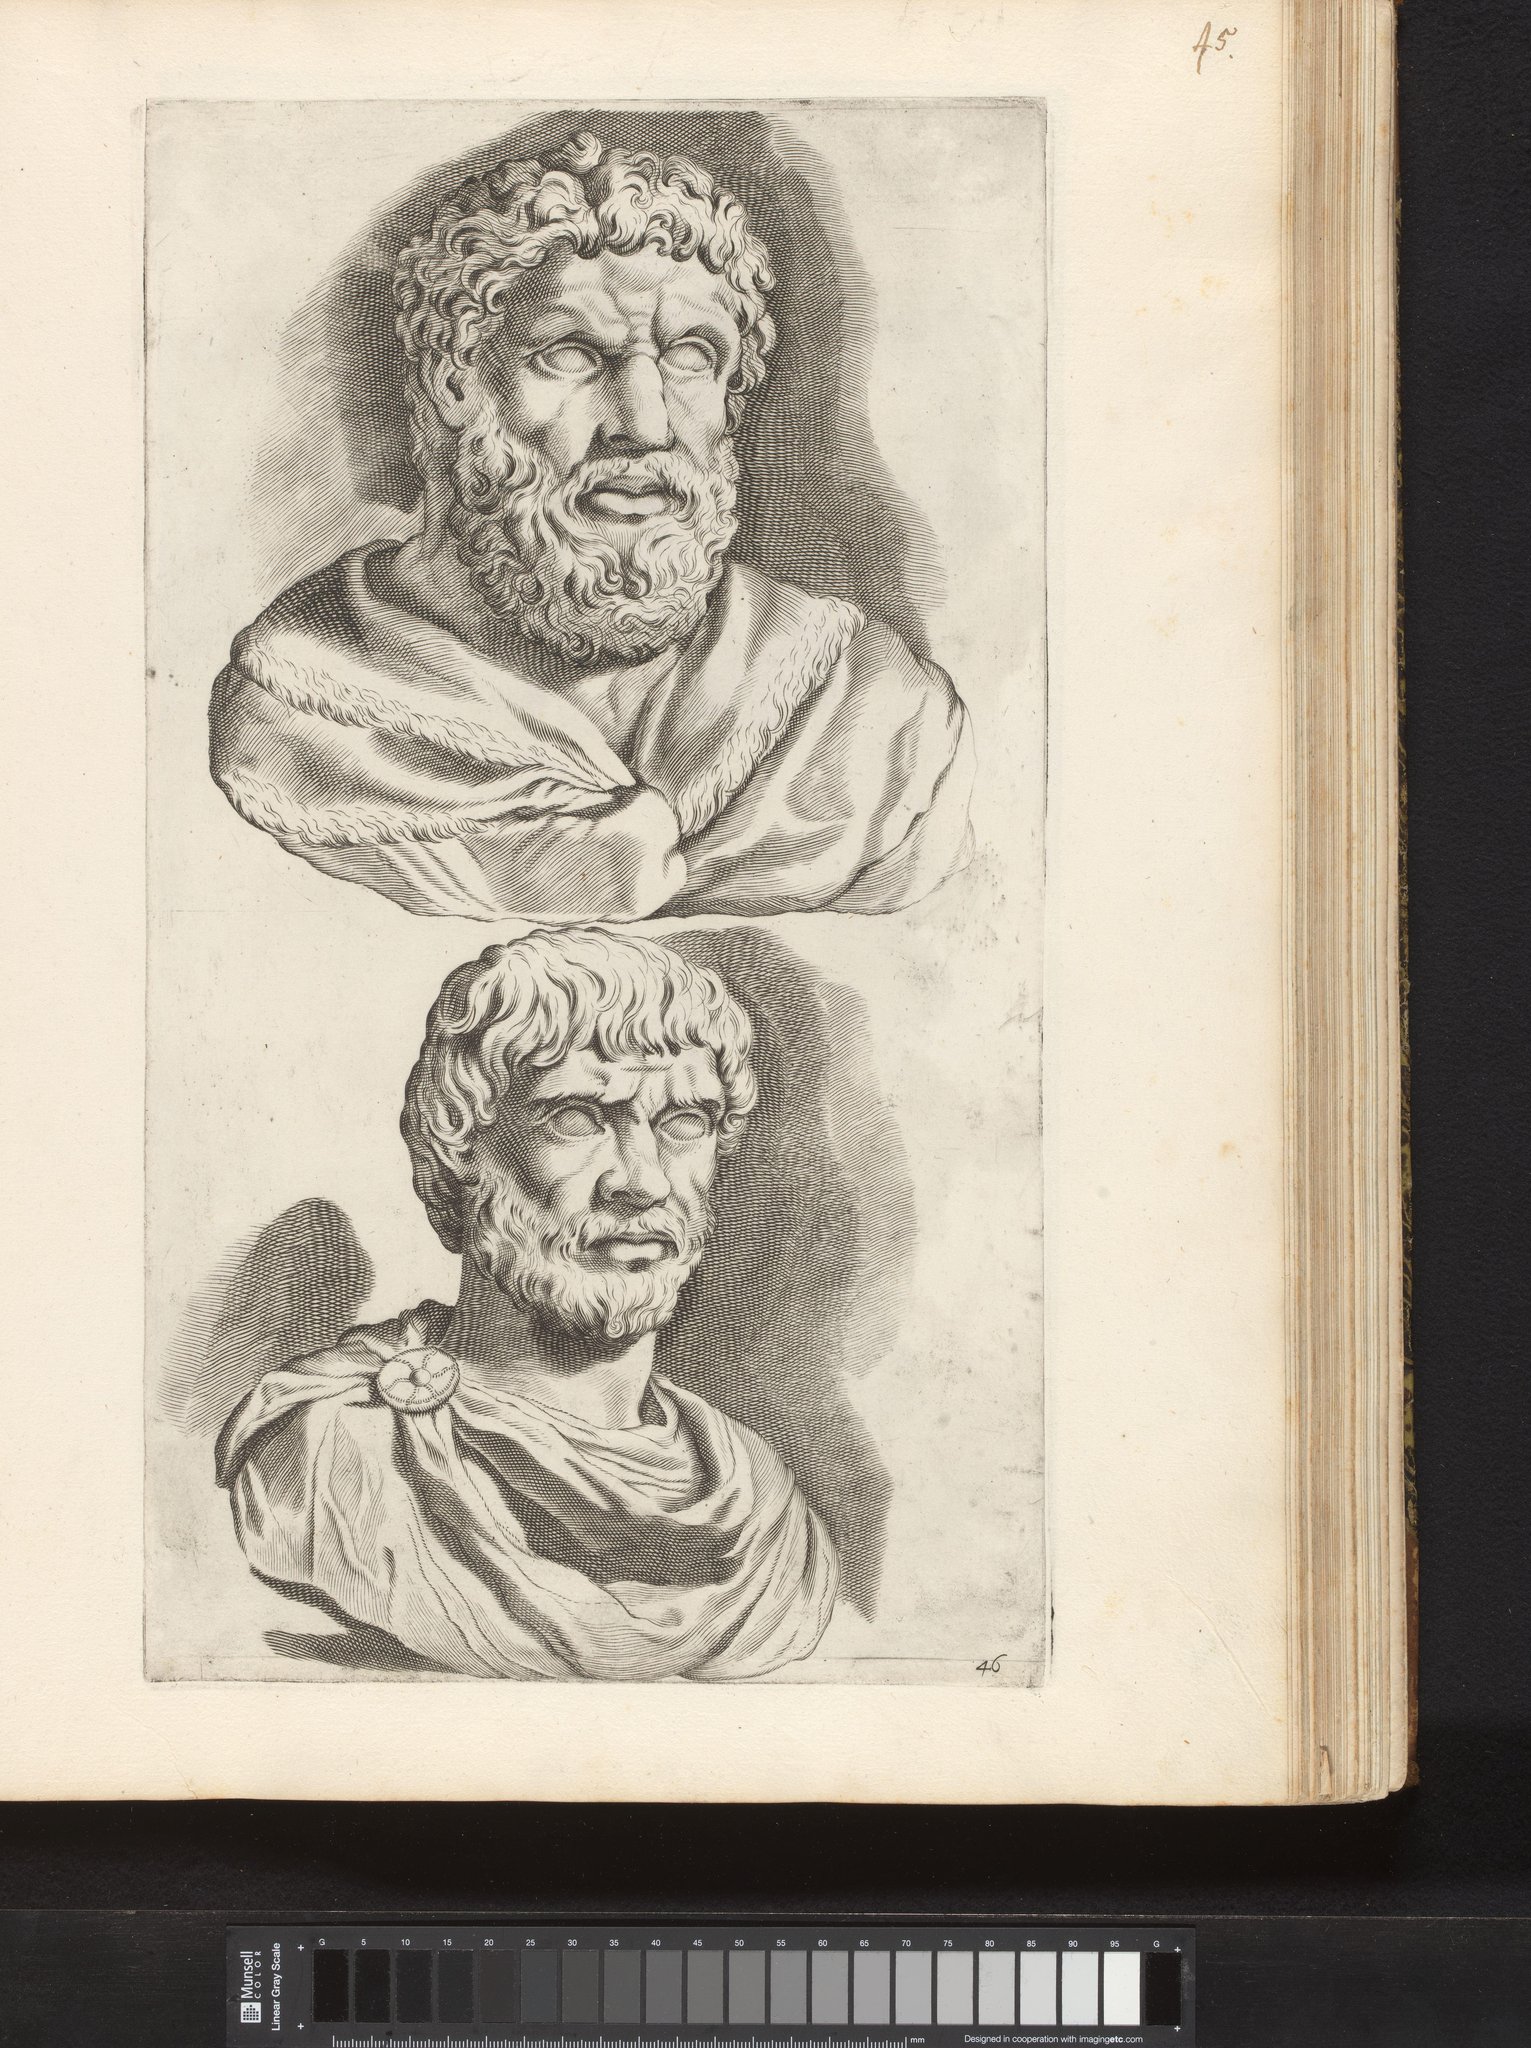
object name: album leaf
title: Bustes van Jupiter Capitolinus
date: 1636-1647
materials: paper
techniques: engraving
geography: rome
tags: (story of) jupiter (zeus), piece of sculpture, reproduction of a piece of sculpture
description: Twee Romeinse sculpturen van Jupiter. Boven het portret van Jupiter met baard. Onder de buste van een bebaarde Jupiter, het hoofd naar links gewend, een kleed over één schouder. Op beide bustes het wapenschild van Vincenzo Giustiniani. Prent maakt deel uit van een album met een serie prenten naar de sculpturen in de verzameling in de Galleria Giustiniani te Rome.